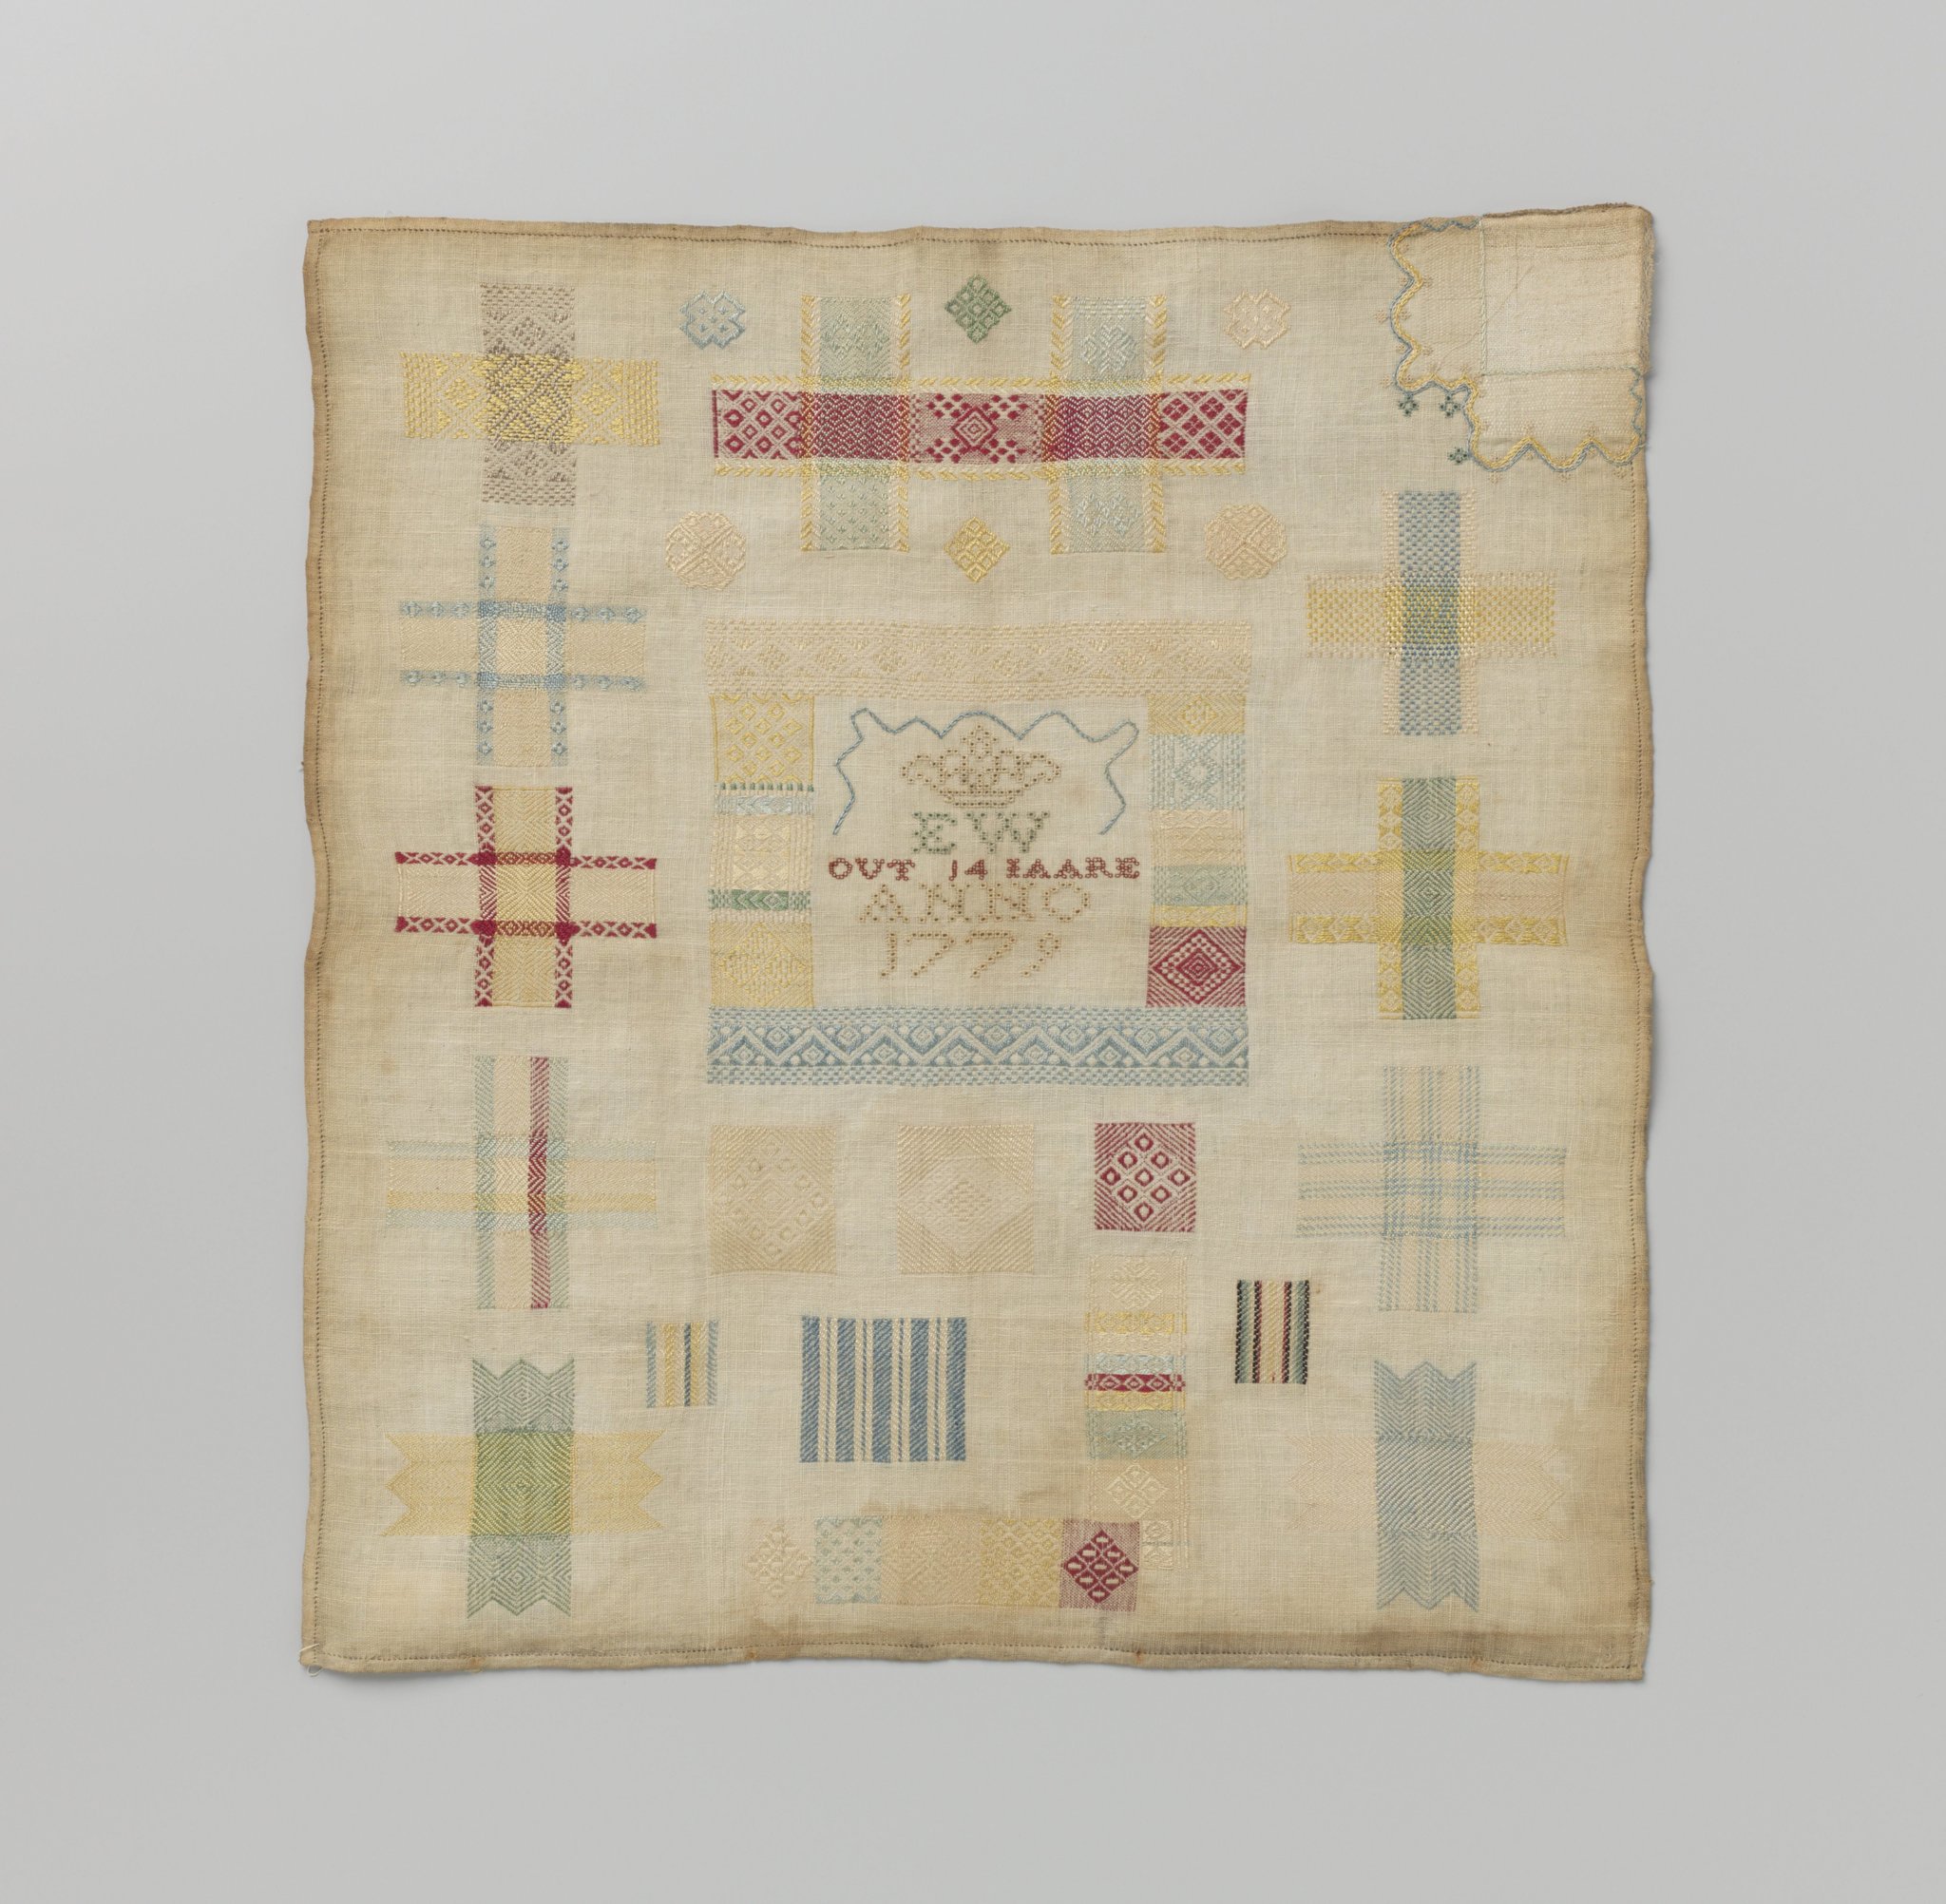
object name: stoplap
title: Stoplap van linnen en zijde op katoenen mousseline.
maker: Anonymous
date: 1779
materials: cotton, linen, silk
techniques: embroidered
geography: haarlem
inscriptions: date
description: Stoplap van linnen en zijde op katoen. Het borduurwerk heeft de gekroonde initialen EW, de tekst OUT 14 IAAR en de datum ANNO 1779.